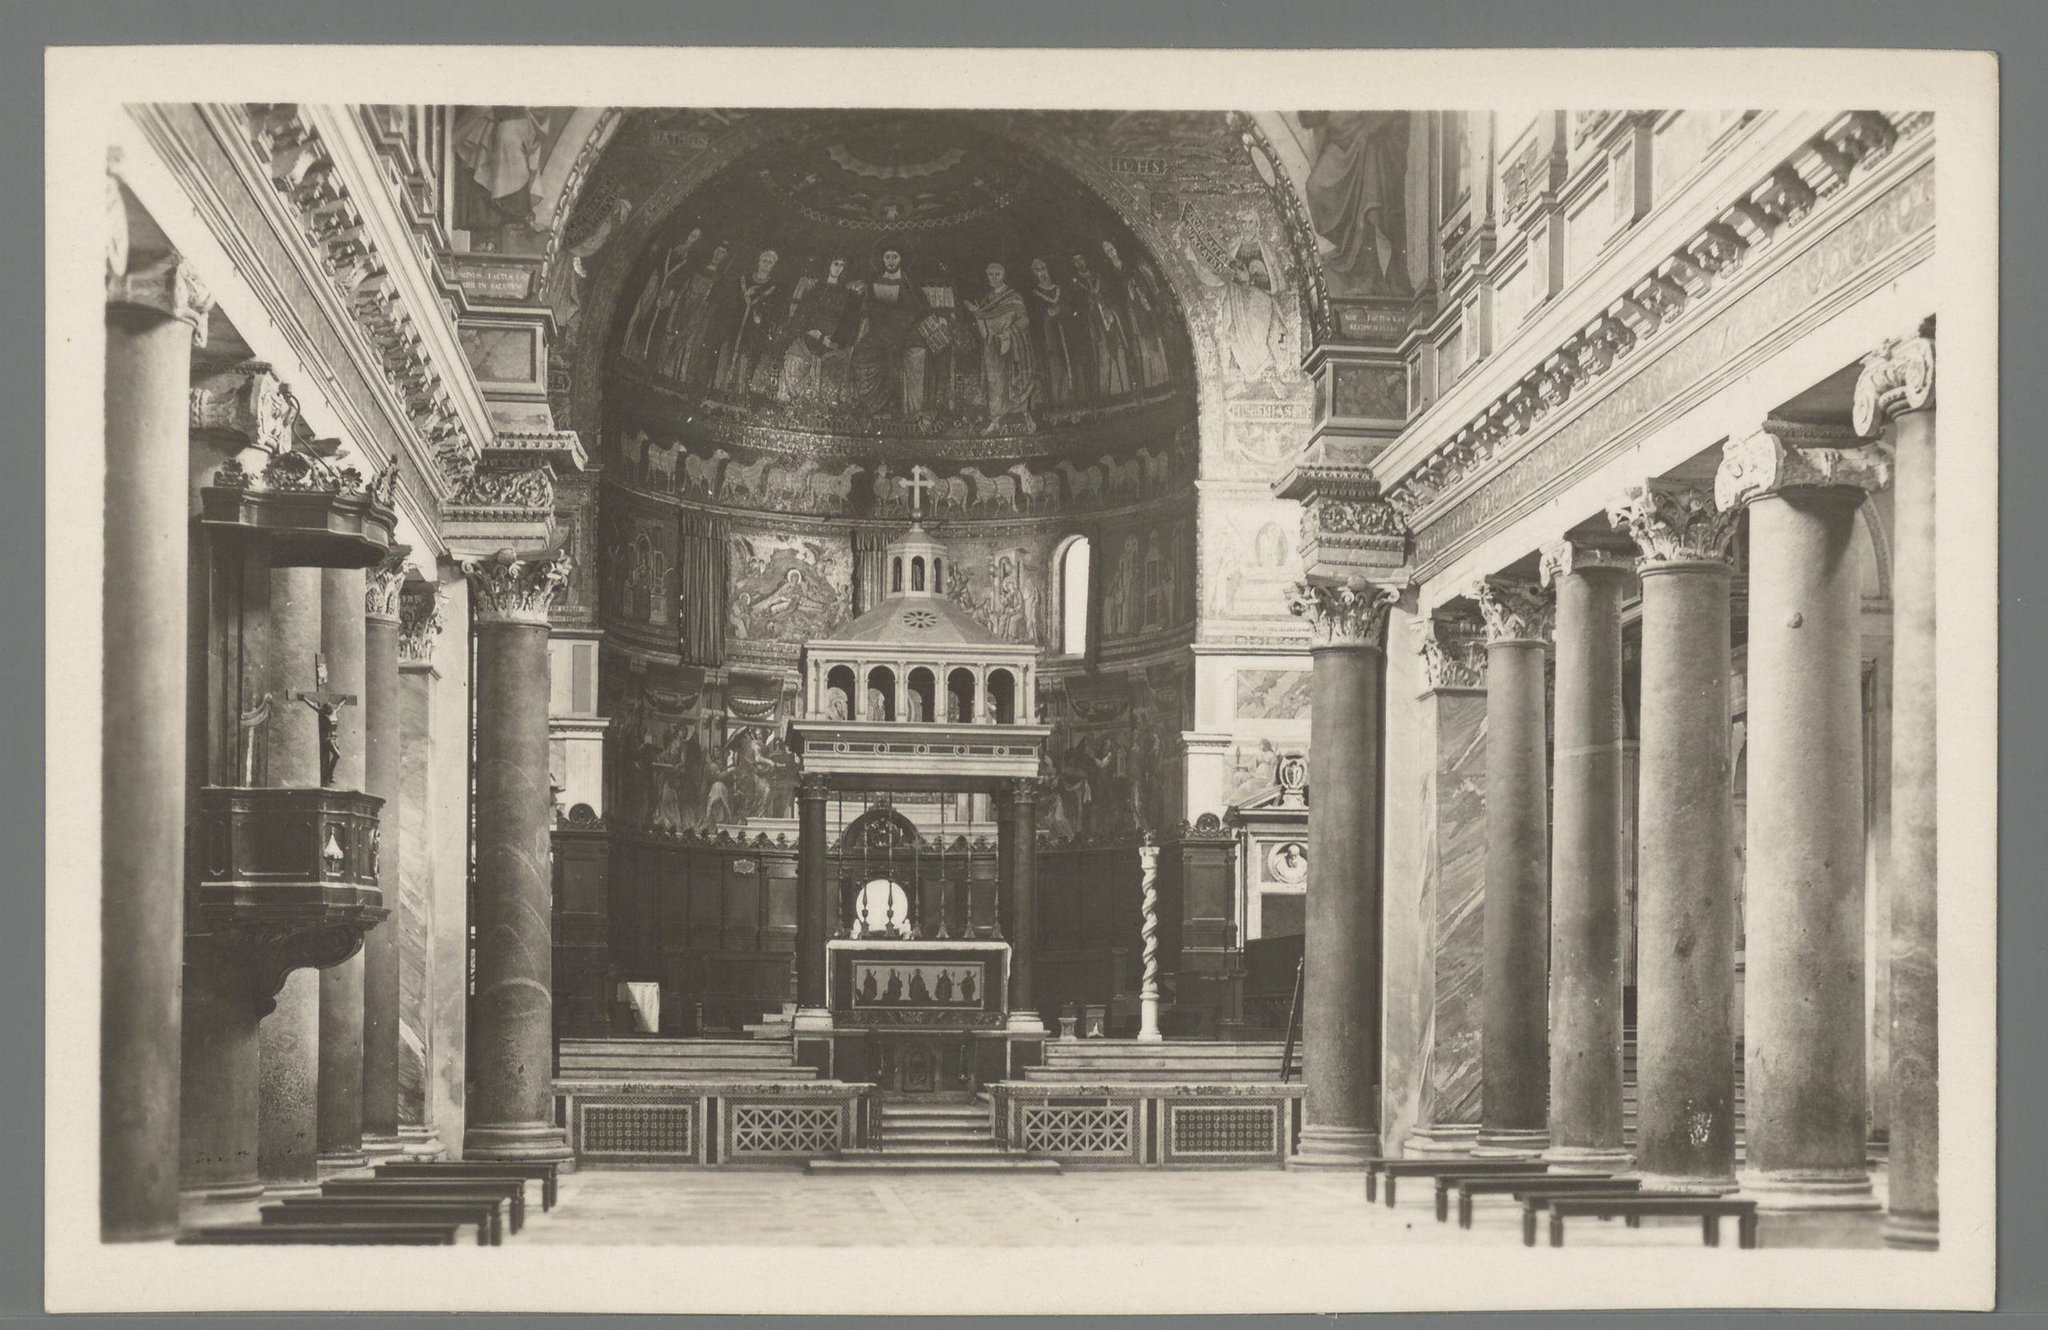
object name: photograph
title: Roma. Interno della Chiesa di S. Maria in Trastevere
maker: Anonymous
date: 1931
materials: photographic support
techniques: photography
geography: rome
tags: interior of church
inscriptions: date